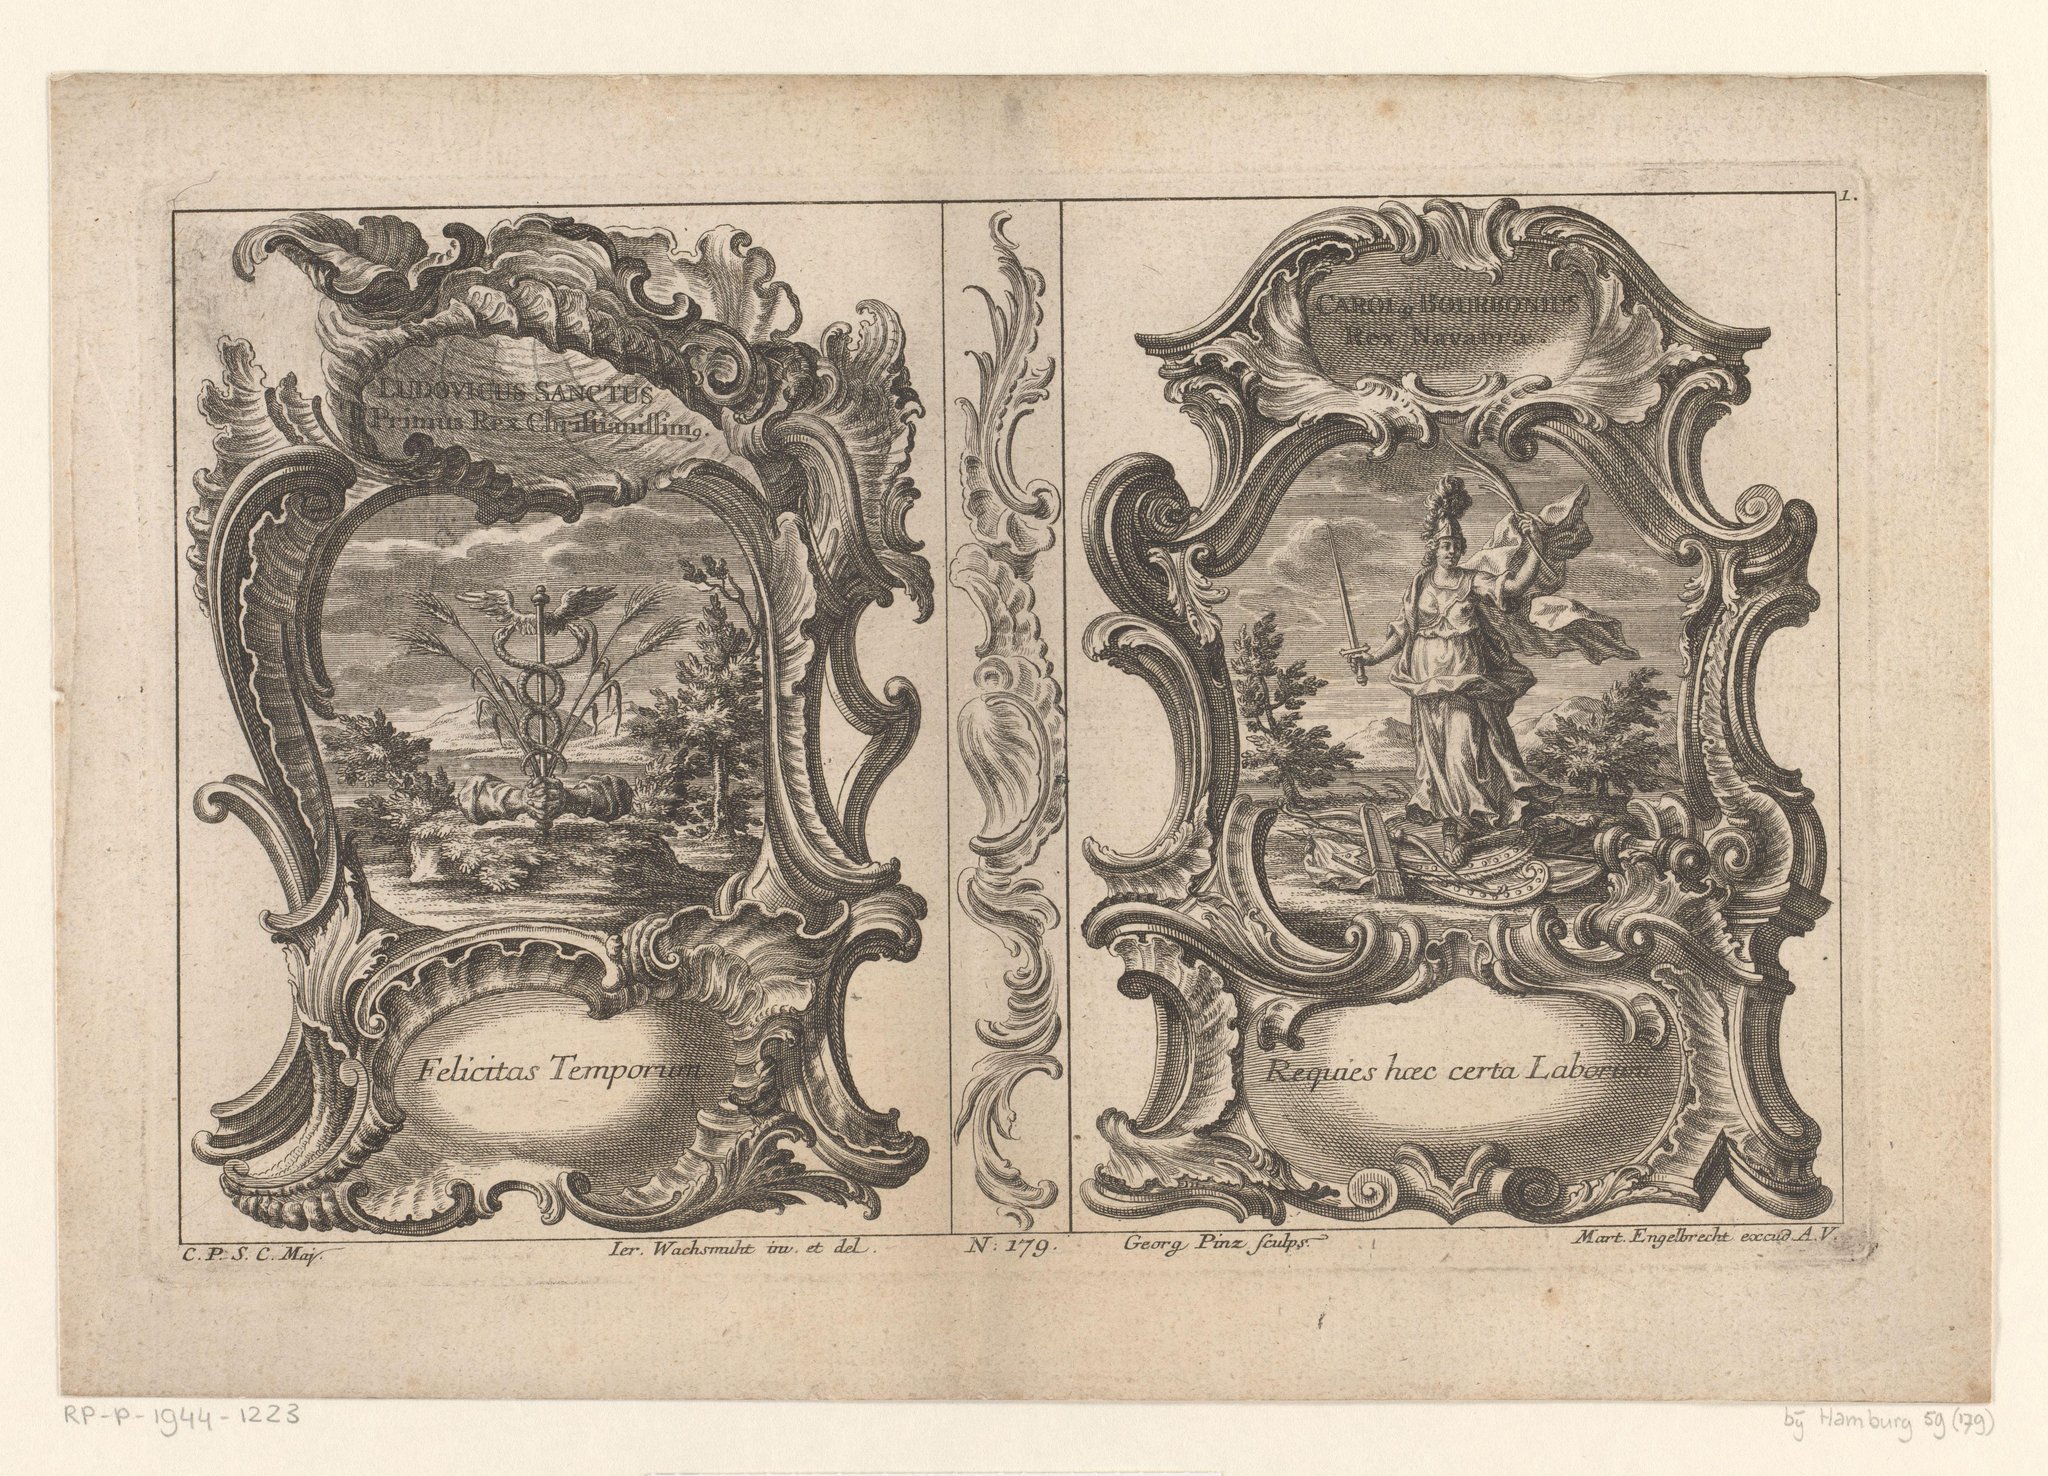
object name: print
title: Symbolische voorstellingen van historische figuren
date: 1721-1756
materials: paper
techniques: etching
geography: augsburg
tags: (story of) minerva (pallas, athena), ornaments ~ art (+ framing decorations), caduceus (staff with two snakes, attribute of mercury)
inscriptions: collector's mark: Lugt 2228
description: Twee rocaille omlijstingen. Links een caduceus met korenaren, vastgehouden door twee handen. Boven en onder de voorstelling de teksten Ludovicus Sanctus Primus Rex Christianissimus, Felicitas Temporum. Rechts staat een gehelmde vrouw, waarschijnlijk Minerva, met een zwaard en palmtak. Bij haar voeten liggen schilden, een pijlenkoker en een boog. Boven en onder de voorstelling de teksten Carolus Bourbonius Rex Navarra, Requies haec certa Laborum. Uitgeversnummer 179.